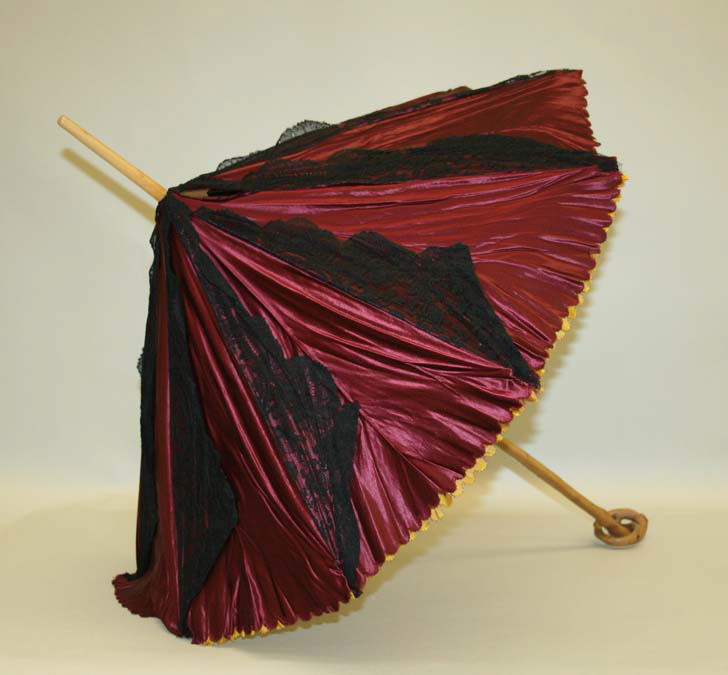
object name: parasol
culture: american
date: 1880-1889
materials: silk, wood